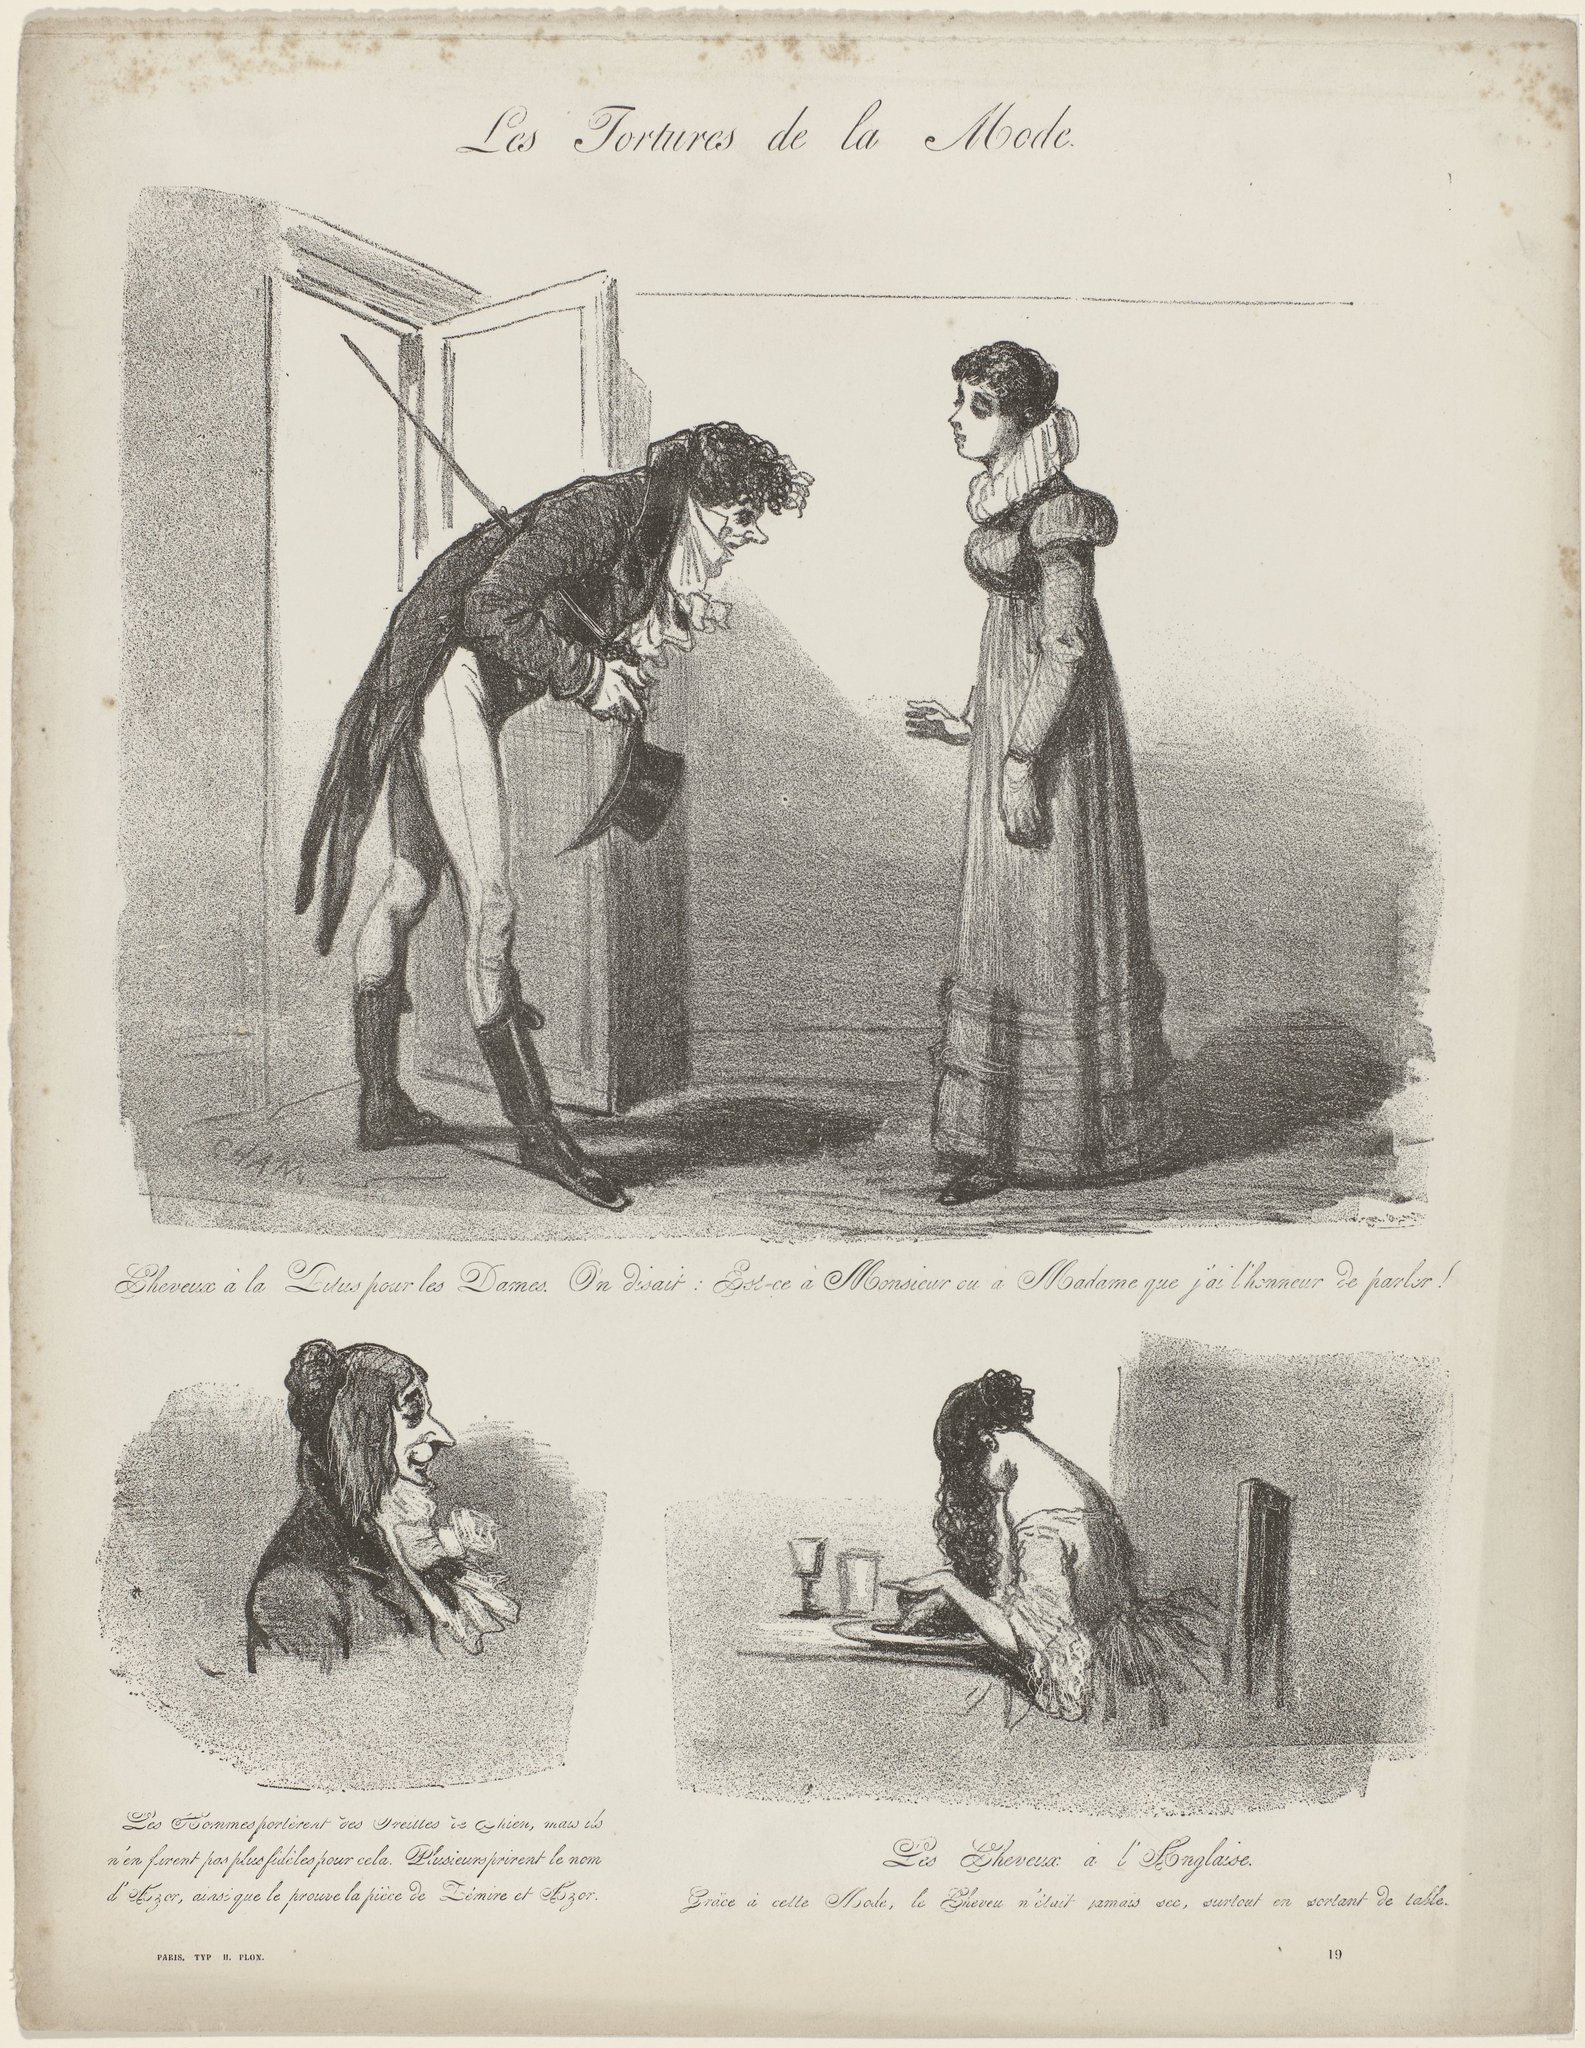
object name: caricature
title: Les Tortures de la Mode, ca. 1848, No. 19 : Cheveux à la Titus (...)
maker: cham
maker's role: print maker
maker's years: 1818-1879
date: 1848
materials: paper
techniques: lithograph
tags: styles of hairdress, fashion plates, clothes, costume (+ women's clothes), head bent forward; bowing, clothes, costume (+ men's clothes), care of the hair - aa - ~ women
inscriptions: caption: ‘Les Hommes porterent des Oreilles se Chien, mais ils n'en firent pas plus fidèles pour cela. Plusieurs prirent le nom d'otuzor, ainsique le prouve la pièce de Témire et Sozor. / Les Cheveux à l'Anglaise. Gräce à celle Mode, le Cheveu n'etait jamais sec, surtout en sorlant de table.’, caption: ‘Cheveux à la Titus pour les Dames. On disaIt: Est-ce à Monsieur ou à Madame que j'ai l'honneur de parler!’, title: ‘Les Tortures de la Mode’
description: Karikatuur van diverse kapsels. Boven: man in een deuropening buigt voor een vrouw met een kapsel 'à la Titus'. Volgens het onderschrift weet hij door het korte haar niet of hij haar met mevrouw of meneer moet aanspreken. Linksonder: mannen dragen het haar als 'Oreilles se Chien' (hondenoren?). Rechtsonder: vrouw waarvan het lange haar op haar bord hangt: 'cheveux à l'anglaise'.